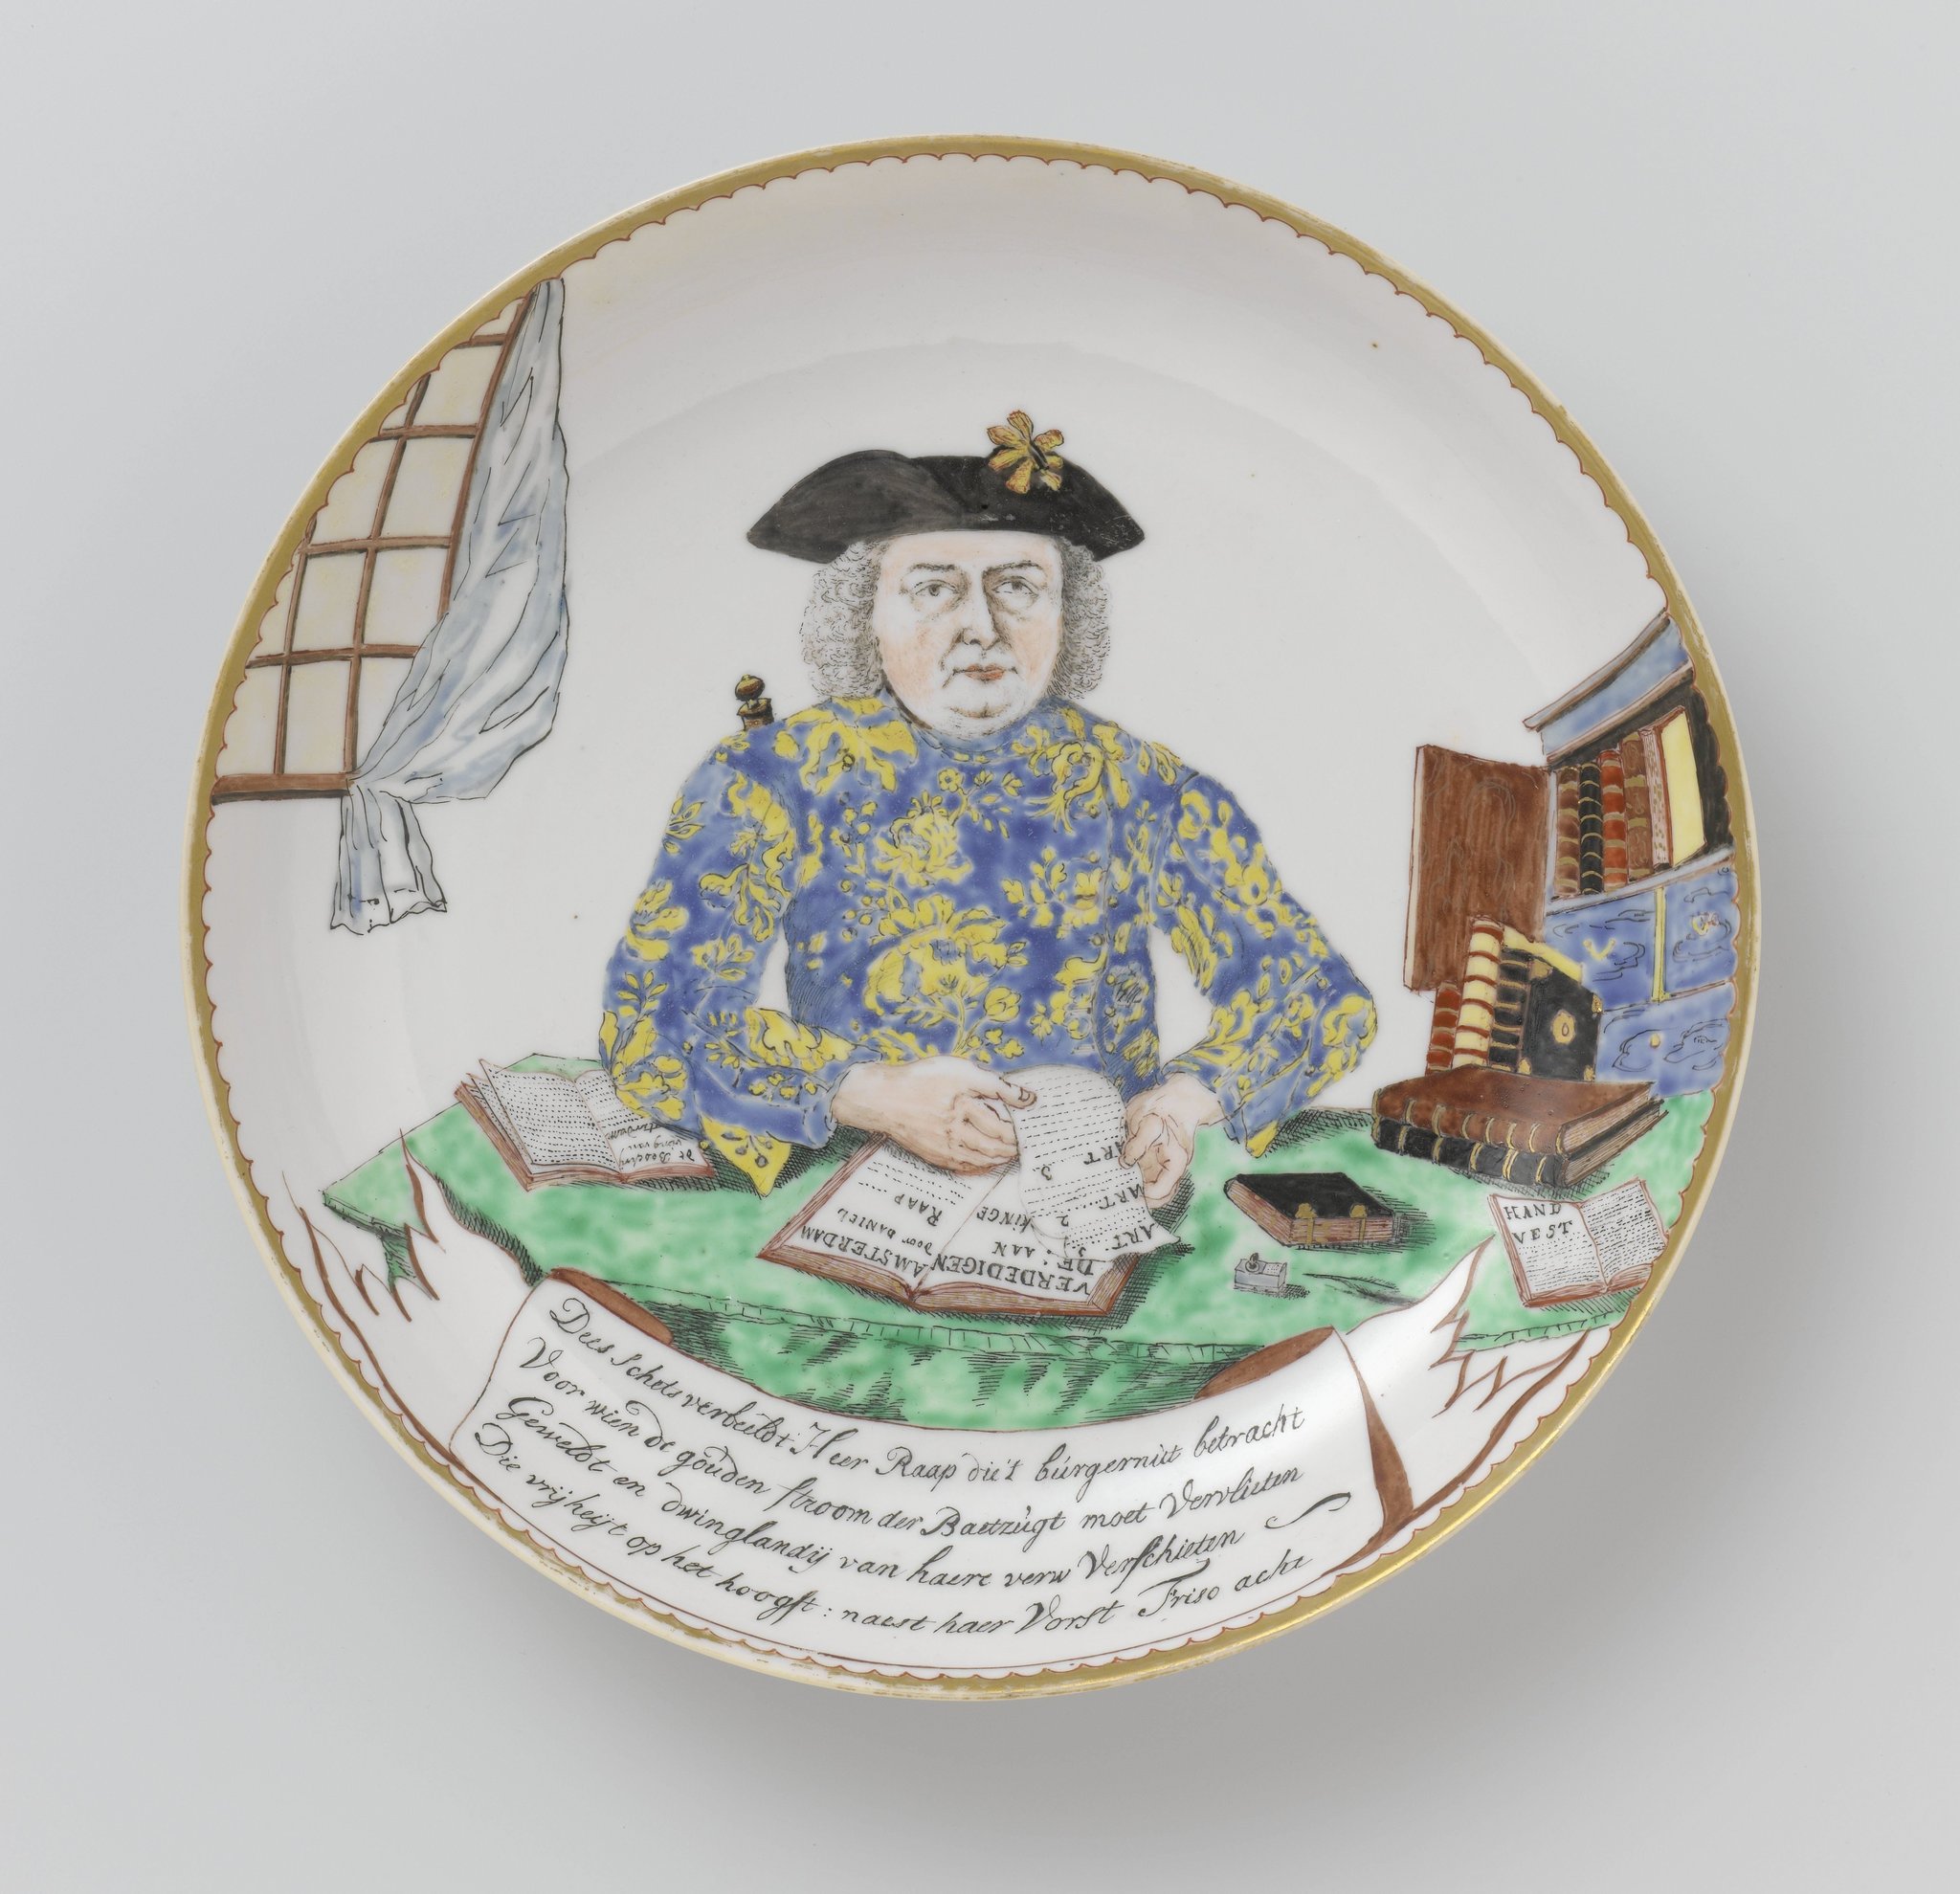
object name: dish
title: Saucer-dish with a portrait of Daniel Raap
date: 1750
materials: glaze, gold, paint, porcelain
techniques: firing, gilding, turning, vitrification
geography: amsterdam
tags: amsterdam, the hague, willem iv (prins van oranje-nassau)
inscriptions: inscription: ‘Dees Schets verbeeldt Heer Raap die't búrgernút betracht / Voor wien de gouden Stroom der Baetzúgt moet Vervlieten / Geweldt en dwingelandij van haere verw Verschieten / Die vrijheijt op het hoogst: naest haer Vorst Friso acht.’, inscription: ‘Ter Vreugd van D' :Heer: Daniel Raap d'Agtenveertigste ver=Jaarring; Word door Elias Colier: dit Afbeeldsel geoffreert. Amsterdam d: 2 jan: 1750/ Pleun Pira fecit/ gb: 1734/ 2/ 7'’, date: ‘d: 2 jan: 1750’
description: Schotel op voetring, gouden rand, naar binnen gekarteld; voorstelling van een man met zwarte hoed en blauwe kimono waarop gele bloemen aan groene tafel waarop boeken en schrijfbenodigdheden, rechts een blauwe kast waarin boeken, links een ruitjesraam met wit gordijn. Op witte achtergrond, opschrift midden onder op banderol. Keerzijde opschrift in het zwart. Gedateerd, gesigneerd en gemerkt.